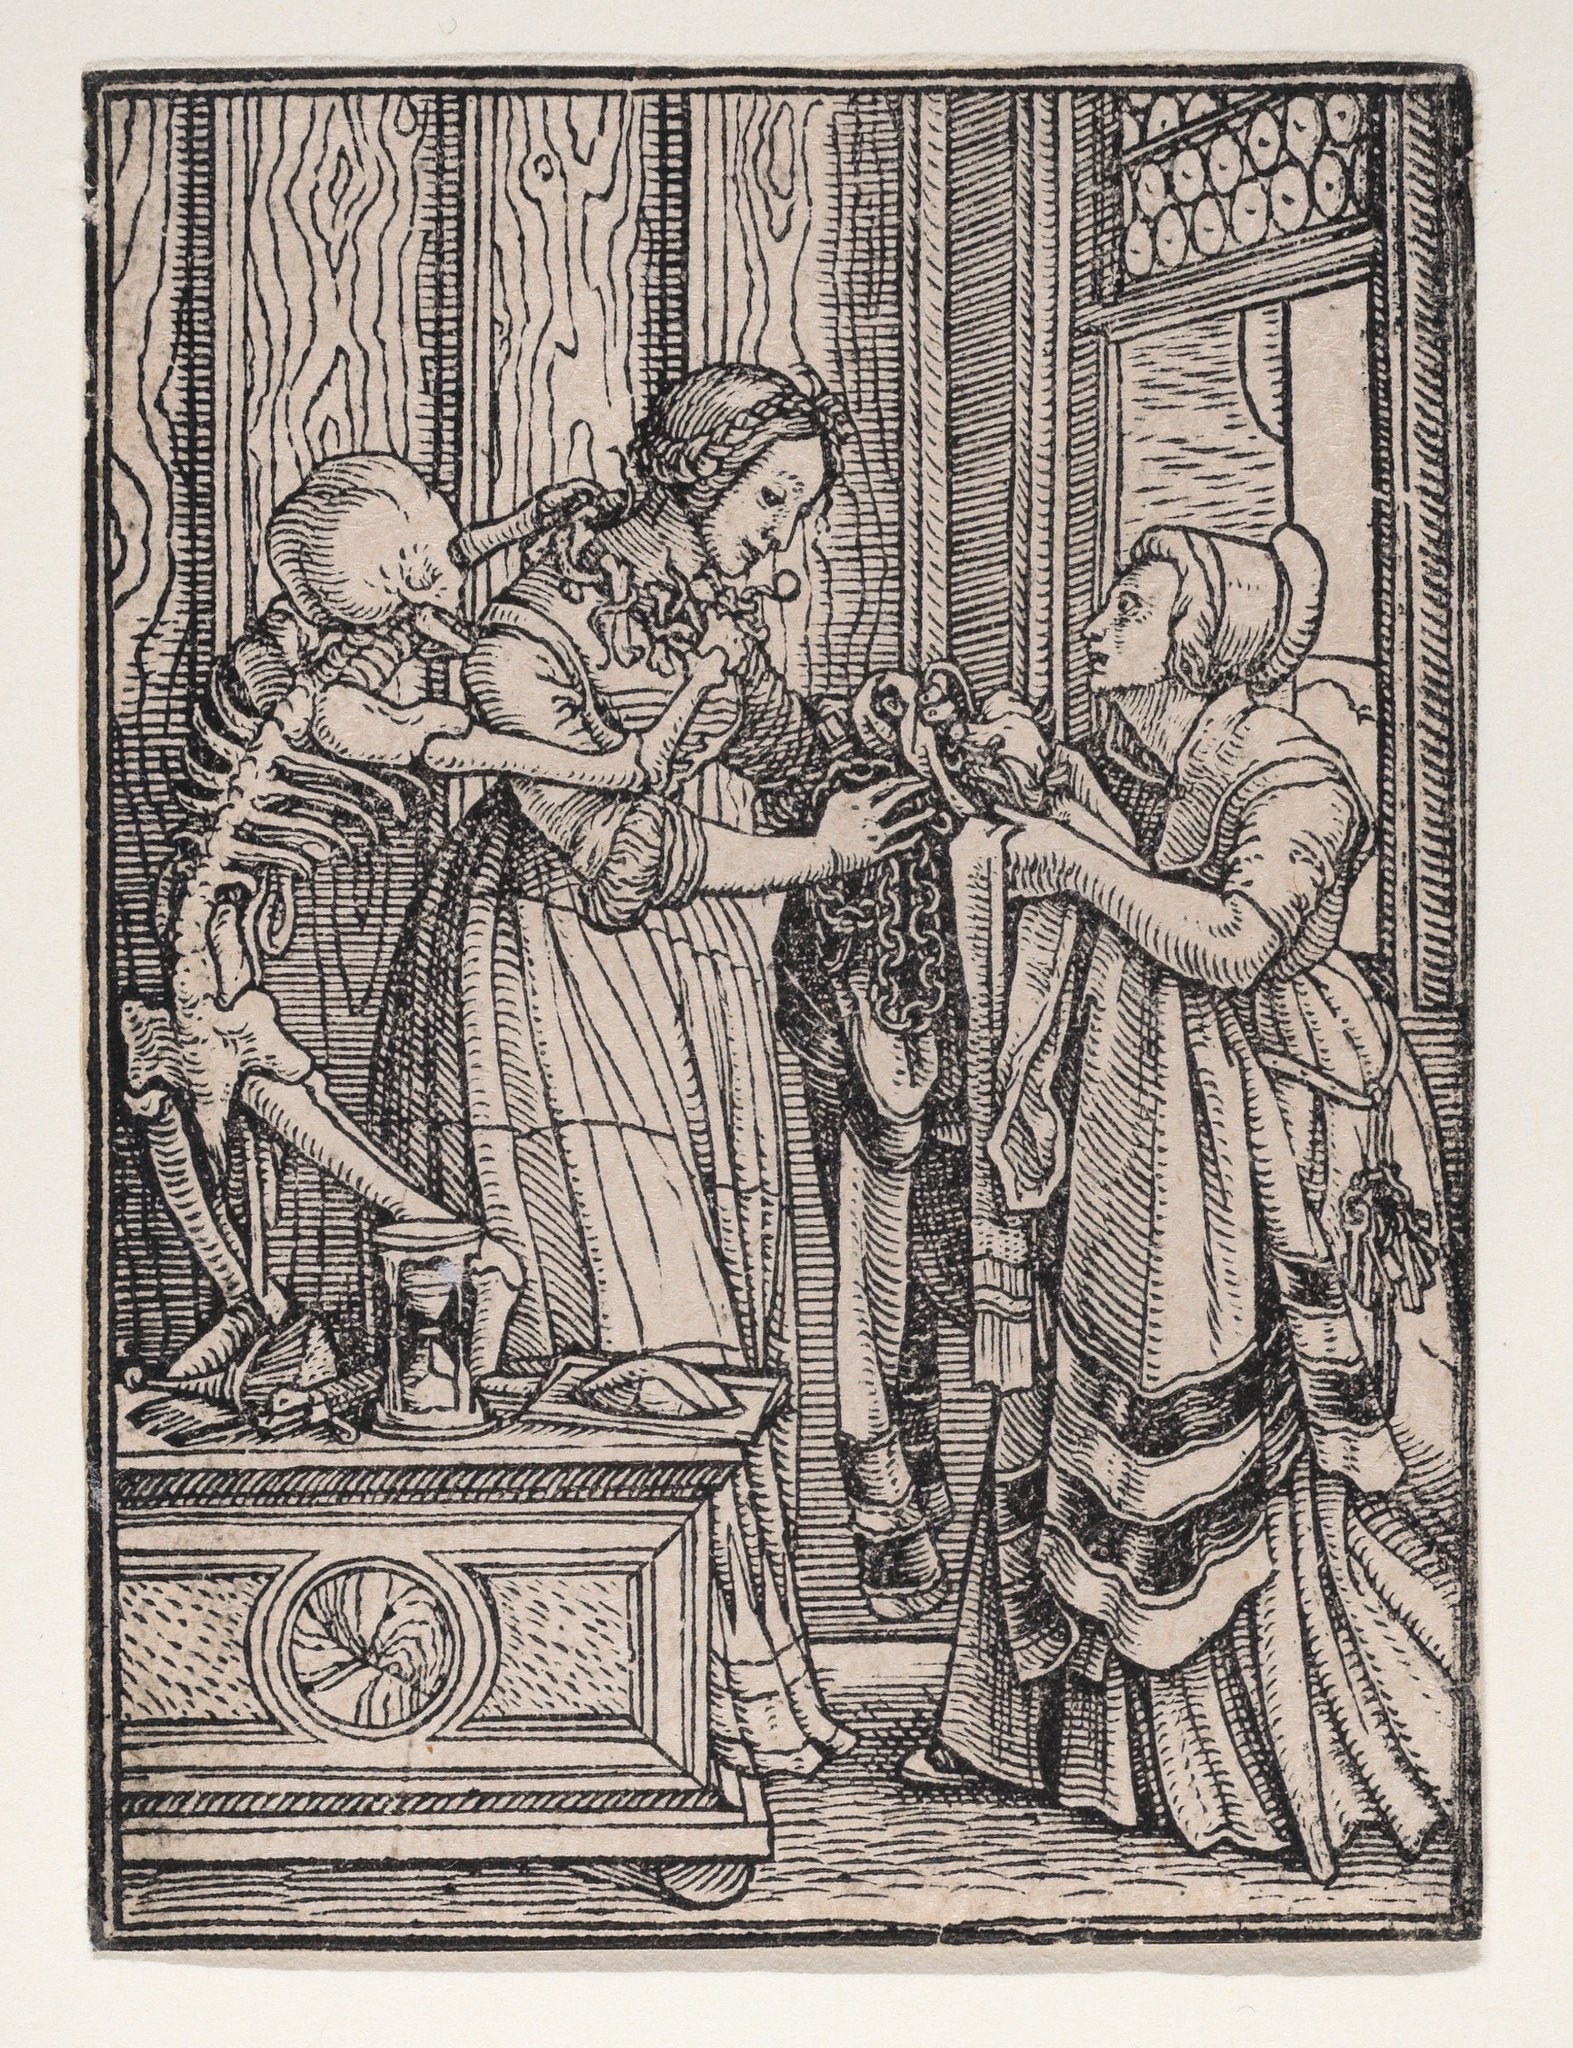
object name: print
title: The Countess, from "The Dance of Death"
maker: hans holbein the younger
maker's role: artist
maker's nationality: german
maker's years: 1497-1543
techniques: woodcut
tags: skeletons,women,hourglass